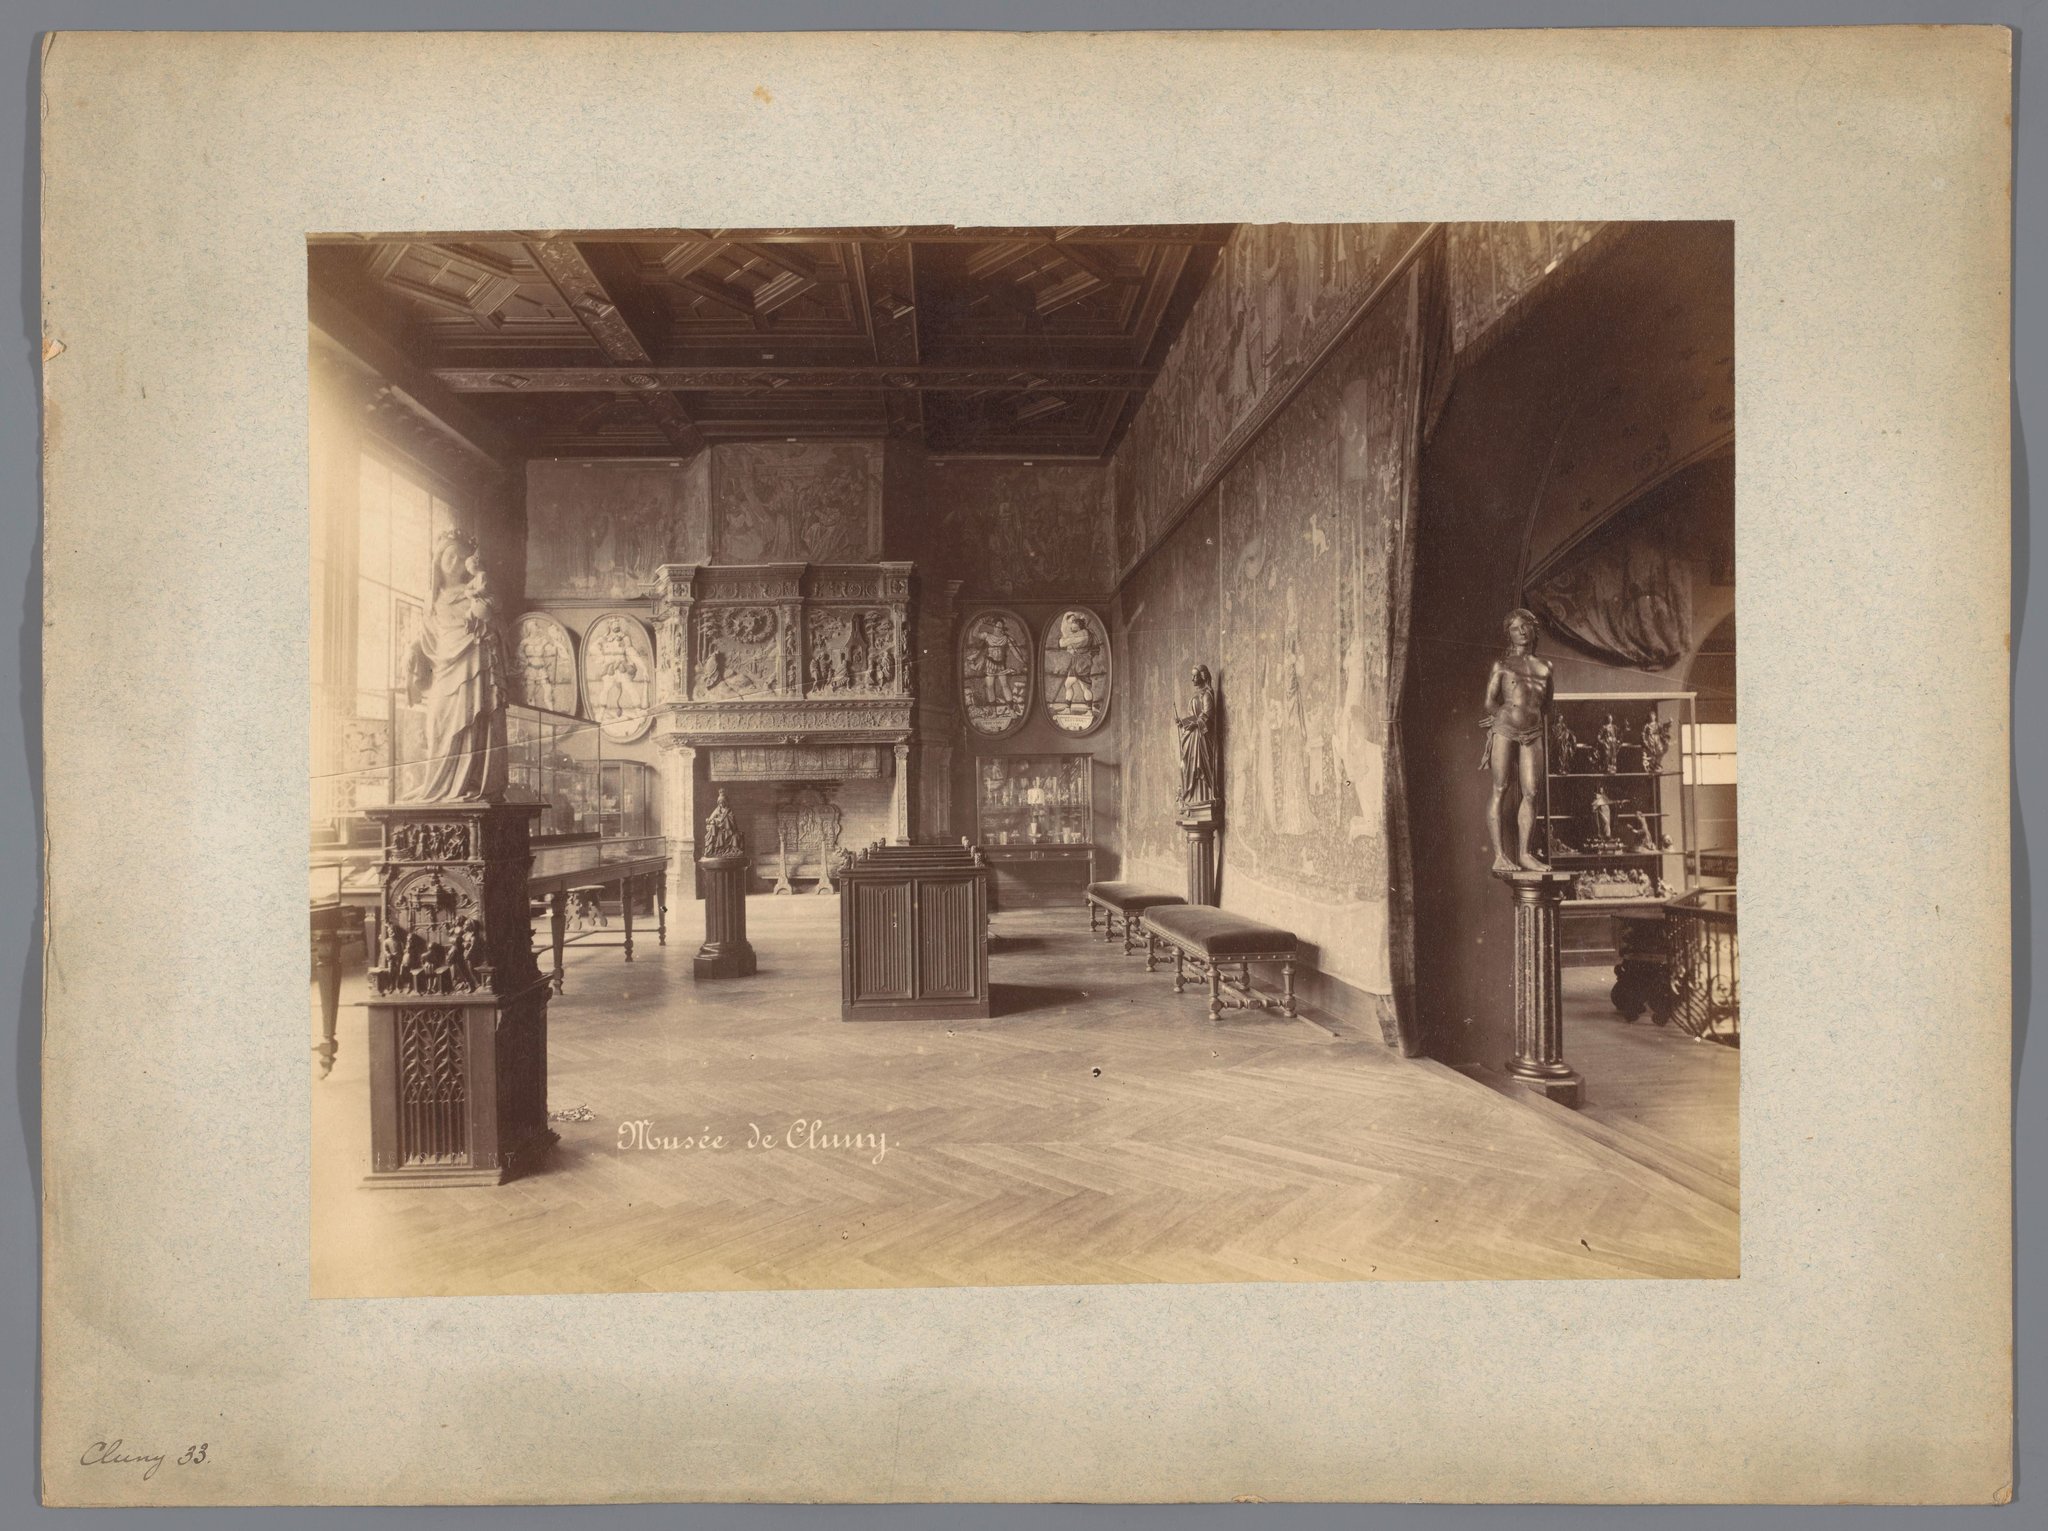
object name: photograph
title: Musée de Cluny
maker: séraphin-médéric mieusement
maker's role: fotograaf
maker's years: 1840-1905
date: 1850-1900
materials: cardboard, photographic support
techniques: albumen print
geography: paris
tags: permanent exhibition, museum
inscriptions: collector's mark: ‘Rijks-normaalschool voor teekenonderwijzers Amsterdam’ Lugt 3937, workshop stamp: ‘Mieusement/ Photographe’, number: ‘Cluny 33’